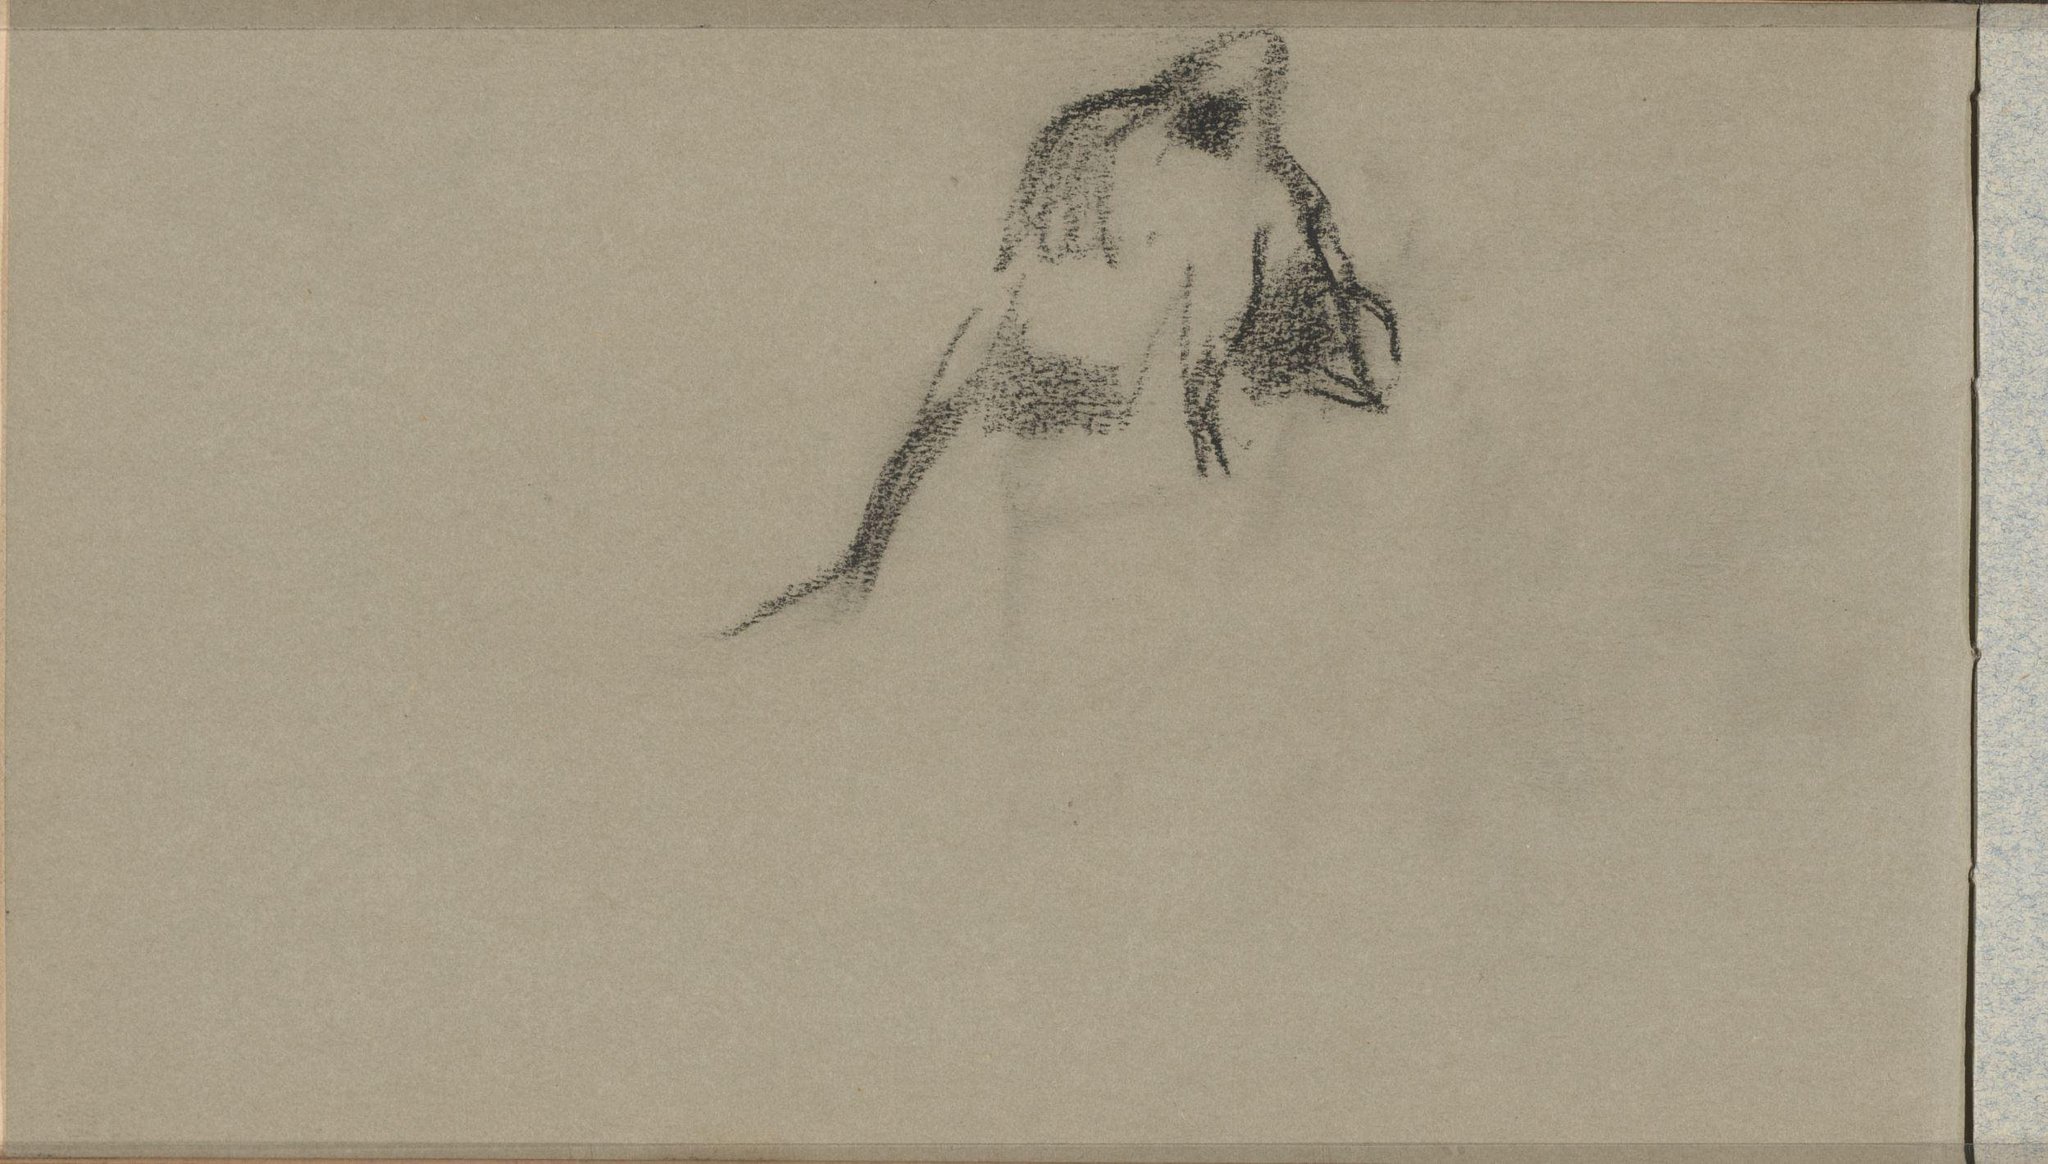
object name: sketchbook leaf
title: Kop van een dier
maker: george hendrik breitner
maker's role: draughtsman, painter, print maker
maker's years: 1857-1923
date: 1883-1885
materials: chalk, paper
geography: drenthe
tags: mammals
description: Pagina 37 uit een schetsboek met 48 bladen.